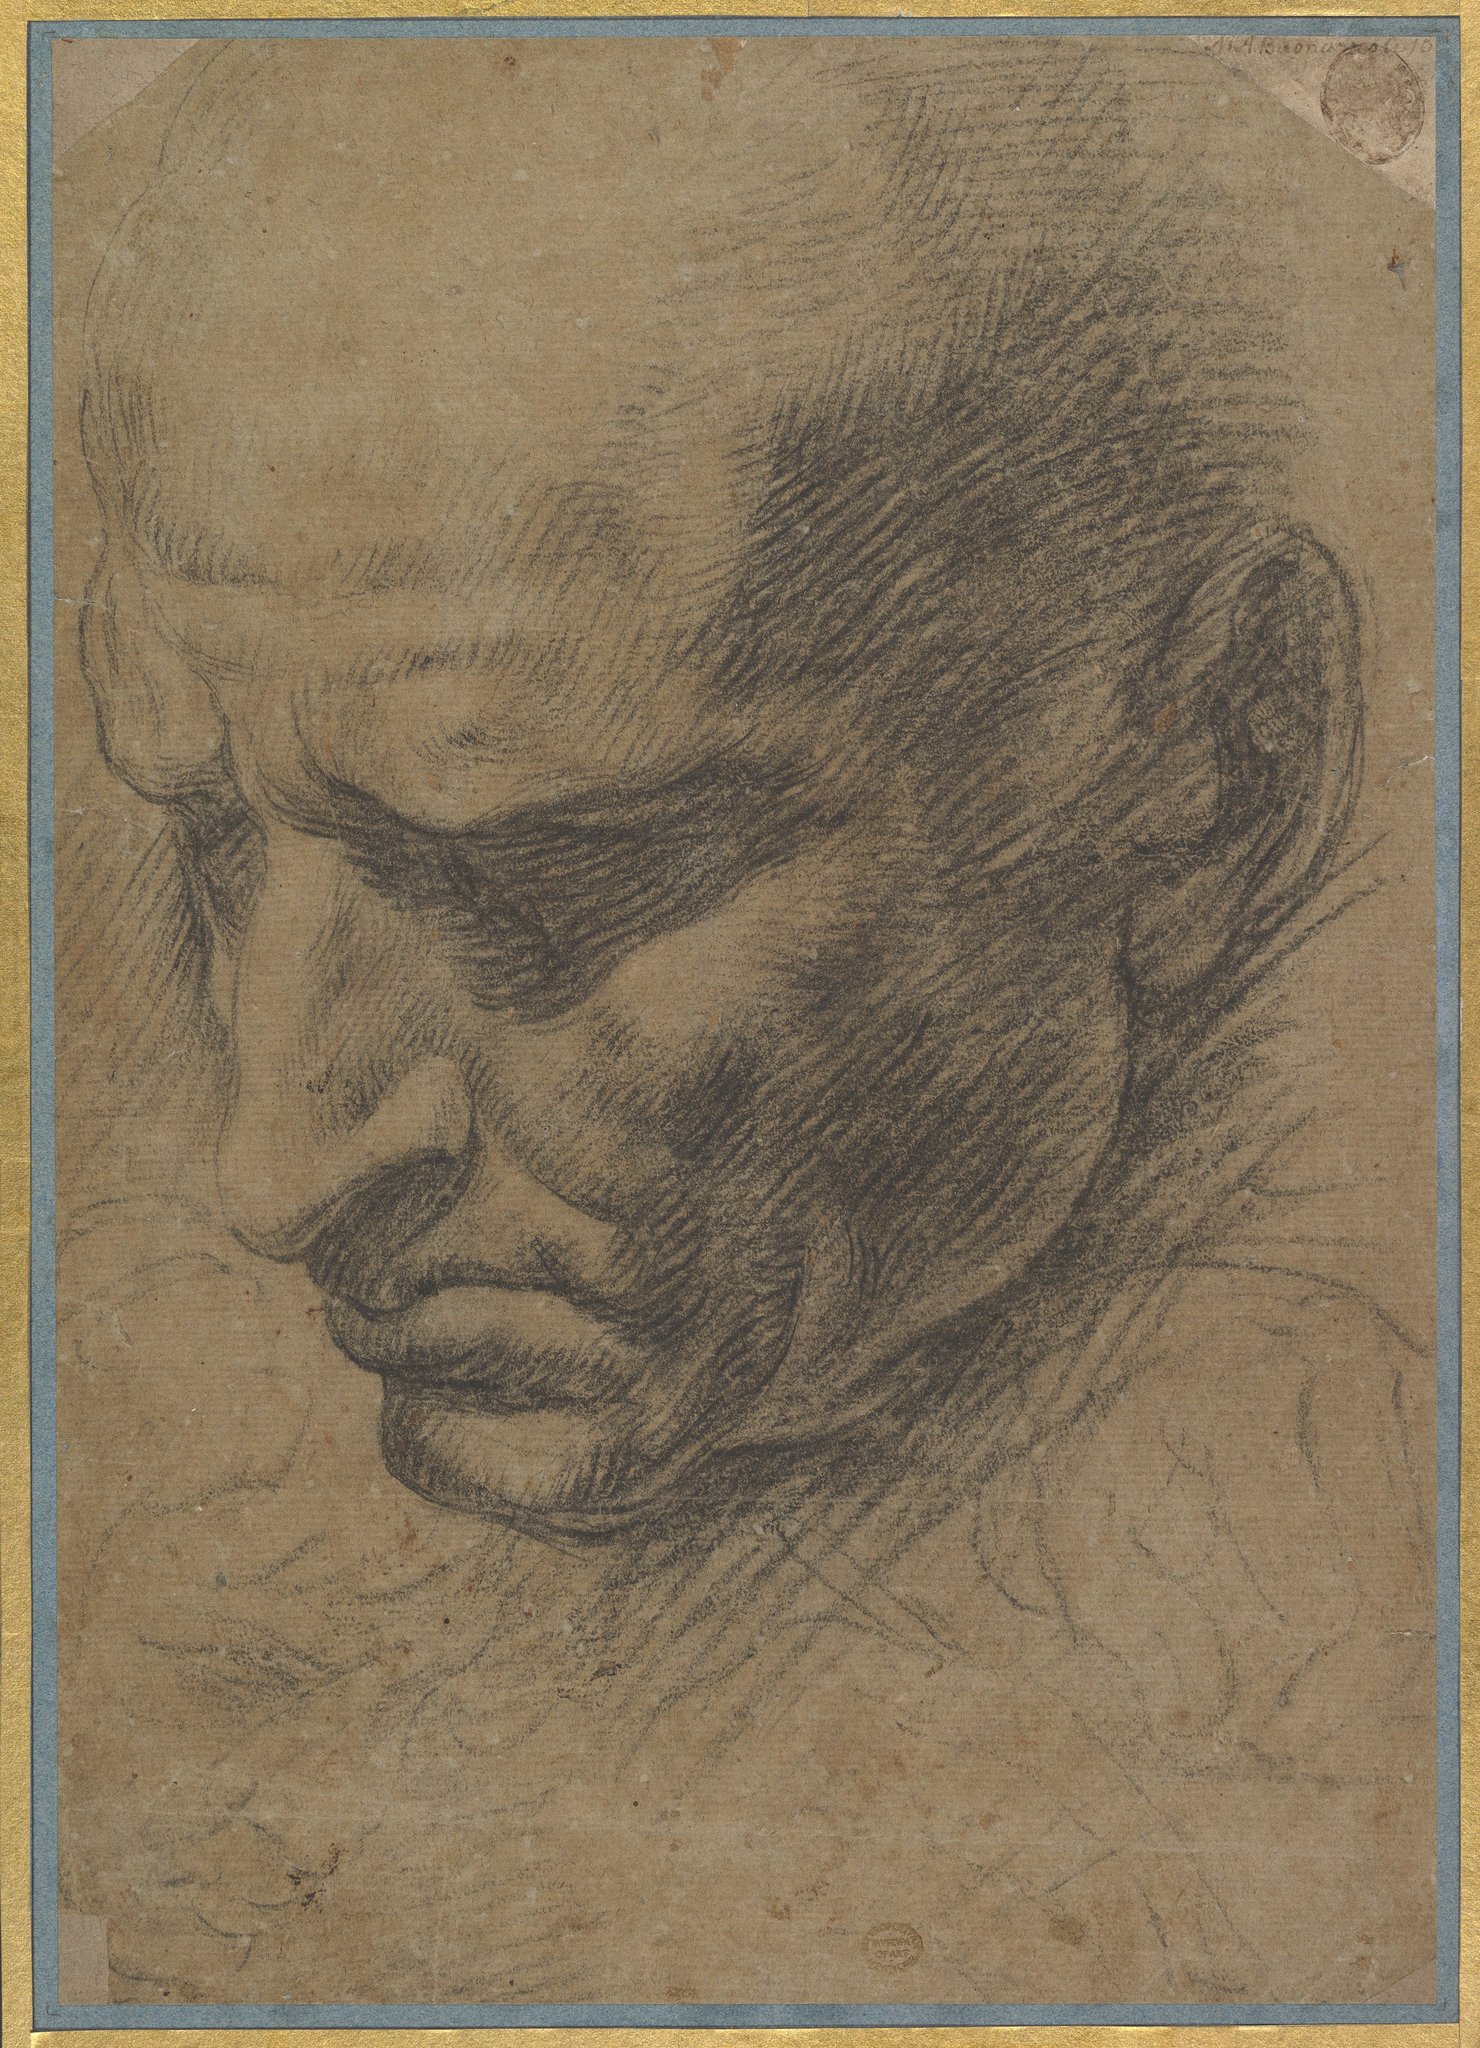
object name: drawing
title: Head of a Man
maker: anonymous, italian, roman, 16th century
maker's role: artist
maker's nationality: italian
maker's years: 1500-1600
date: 1501-1600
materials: chalk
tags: heads,men